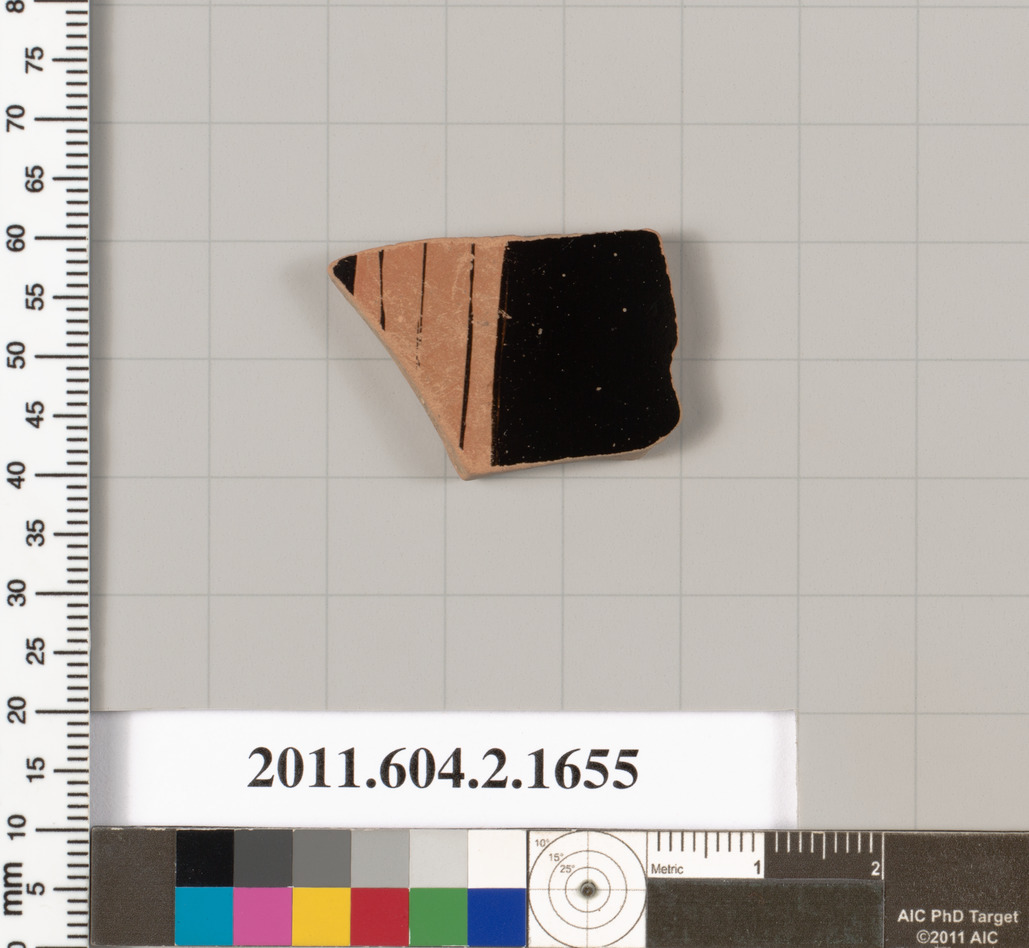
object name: skyphos fragment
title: Terracotta fragment of a skyphos (deep drinking cup)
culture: greek, attic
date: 460-440 BCE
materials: terracotta